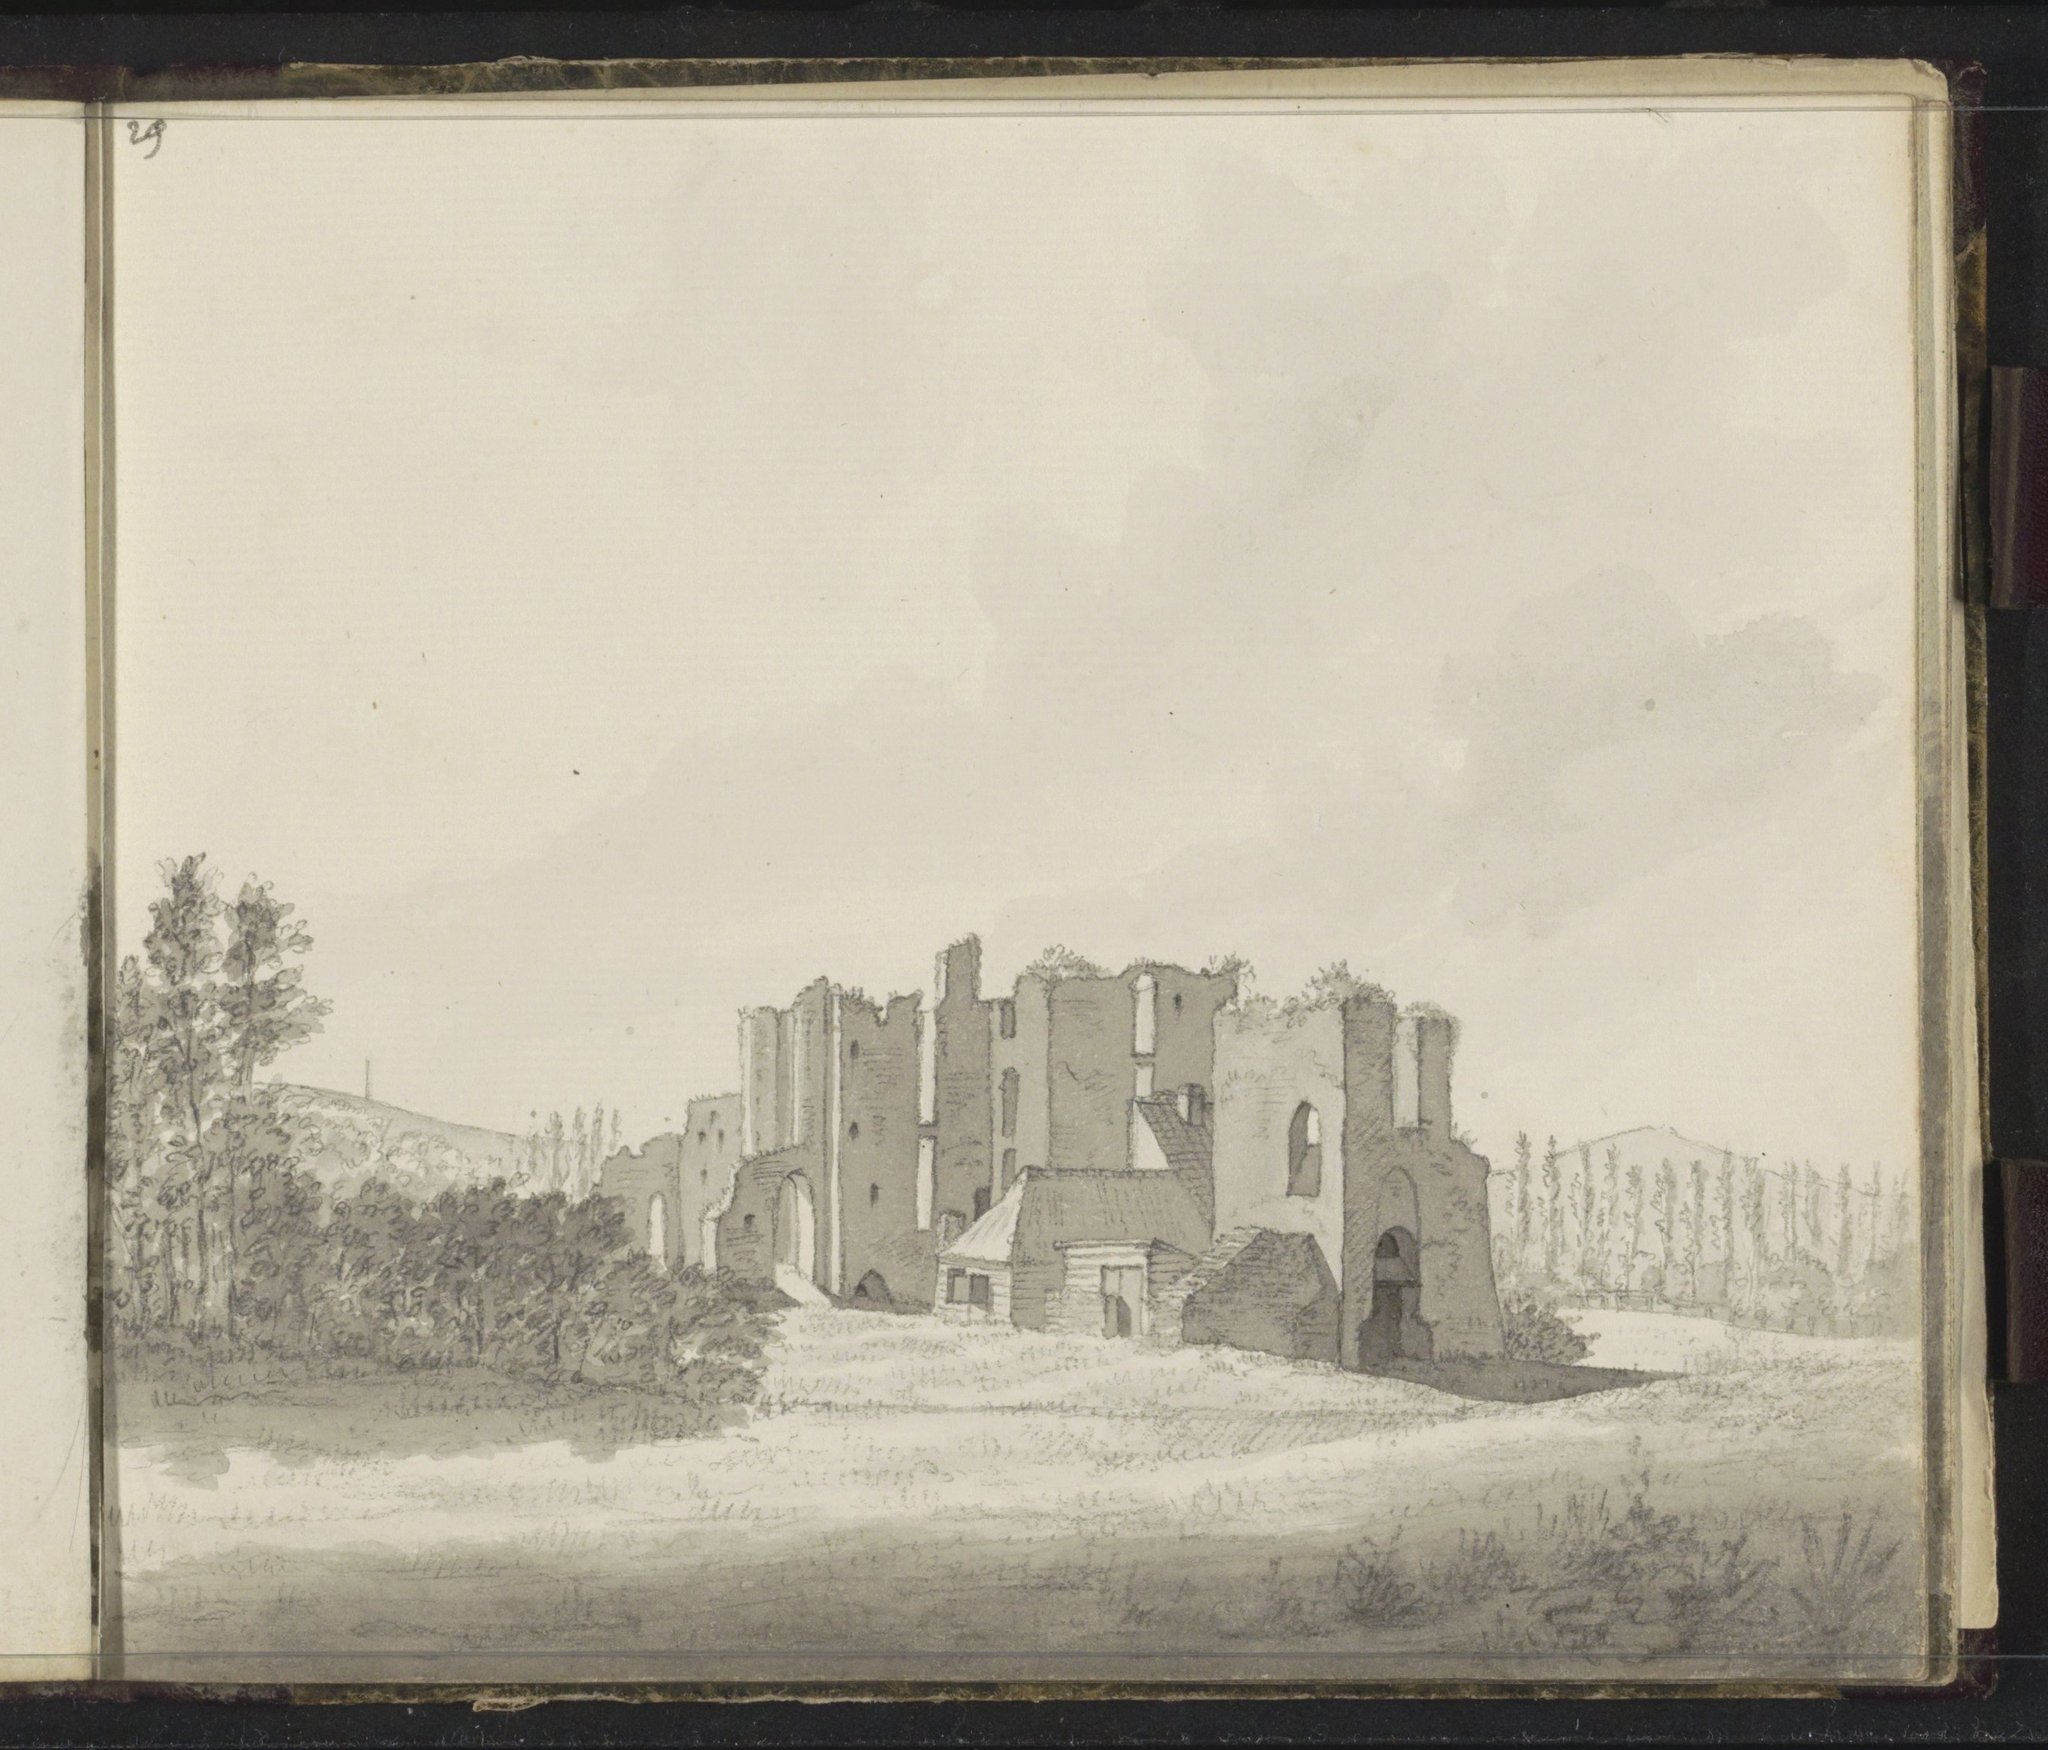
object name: sketchbook leaf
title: Landschap met een ruïne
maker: hendrik abraham klinkhamer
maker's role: draughtsman, painter, print maker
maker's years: 1810-1872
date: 1820-1872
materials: chalk, paper, watercolor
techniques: brush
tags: landscape with ruins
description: Blad 29 recto uit een schetsboek met 39 bladen.